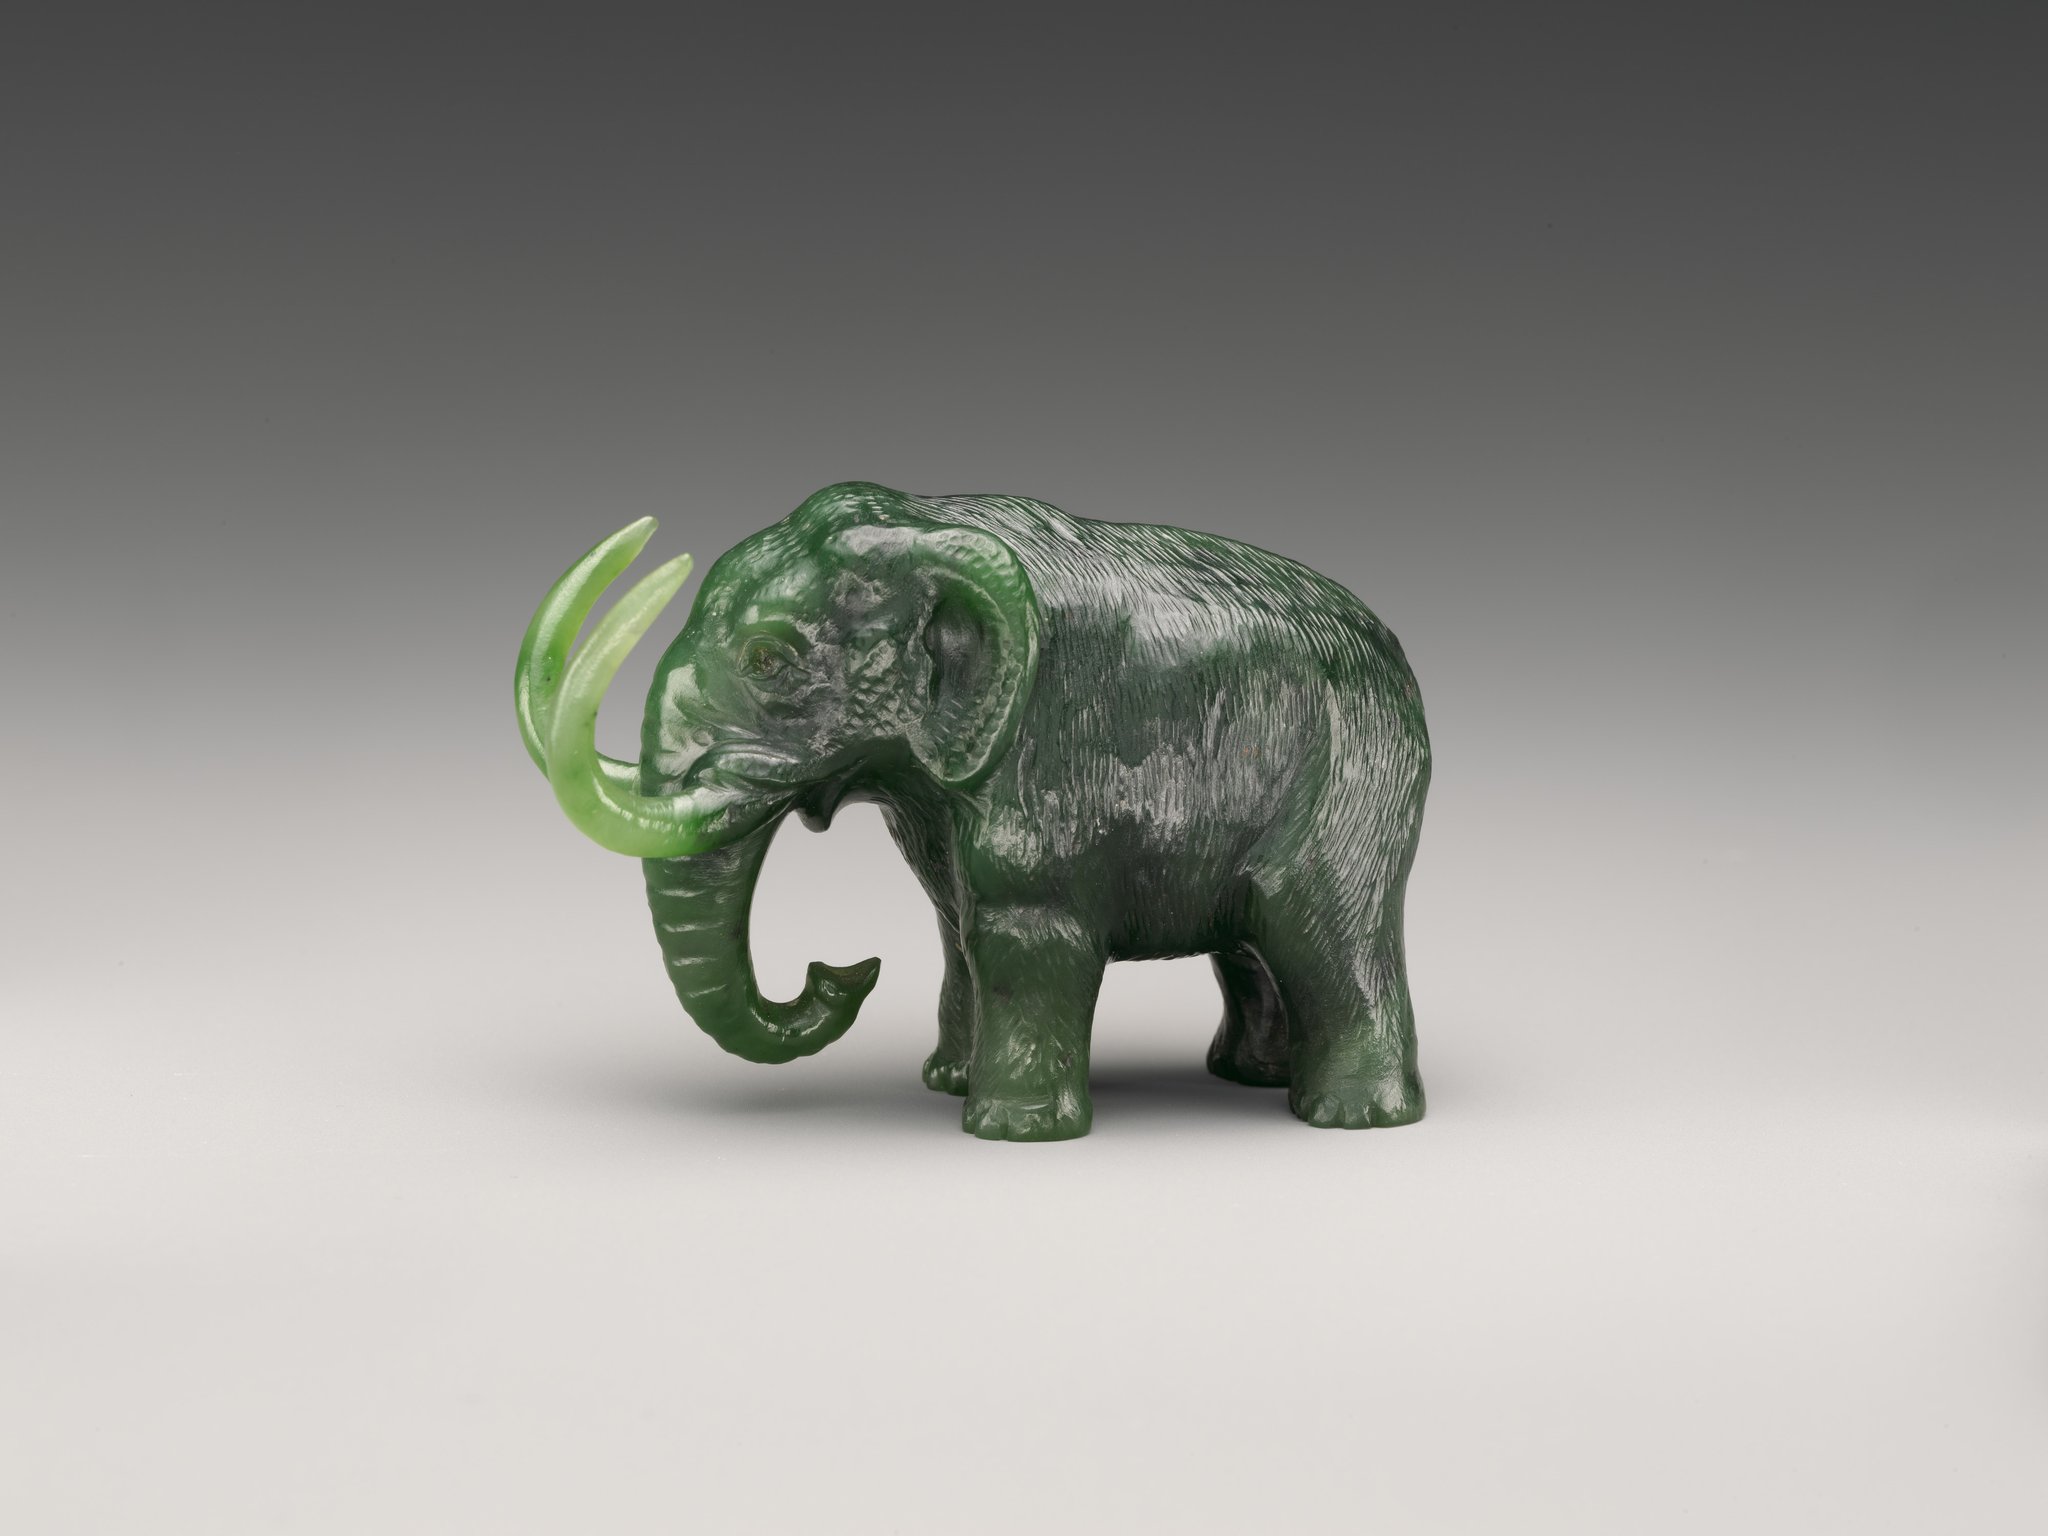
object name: figure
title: Miniature mammoth of Siberia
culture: russian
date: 1900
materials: jade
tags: animals